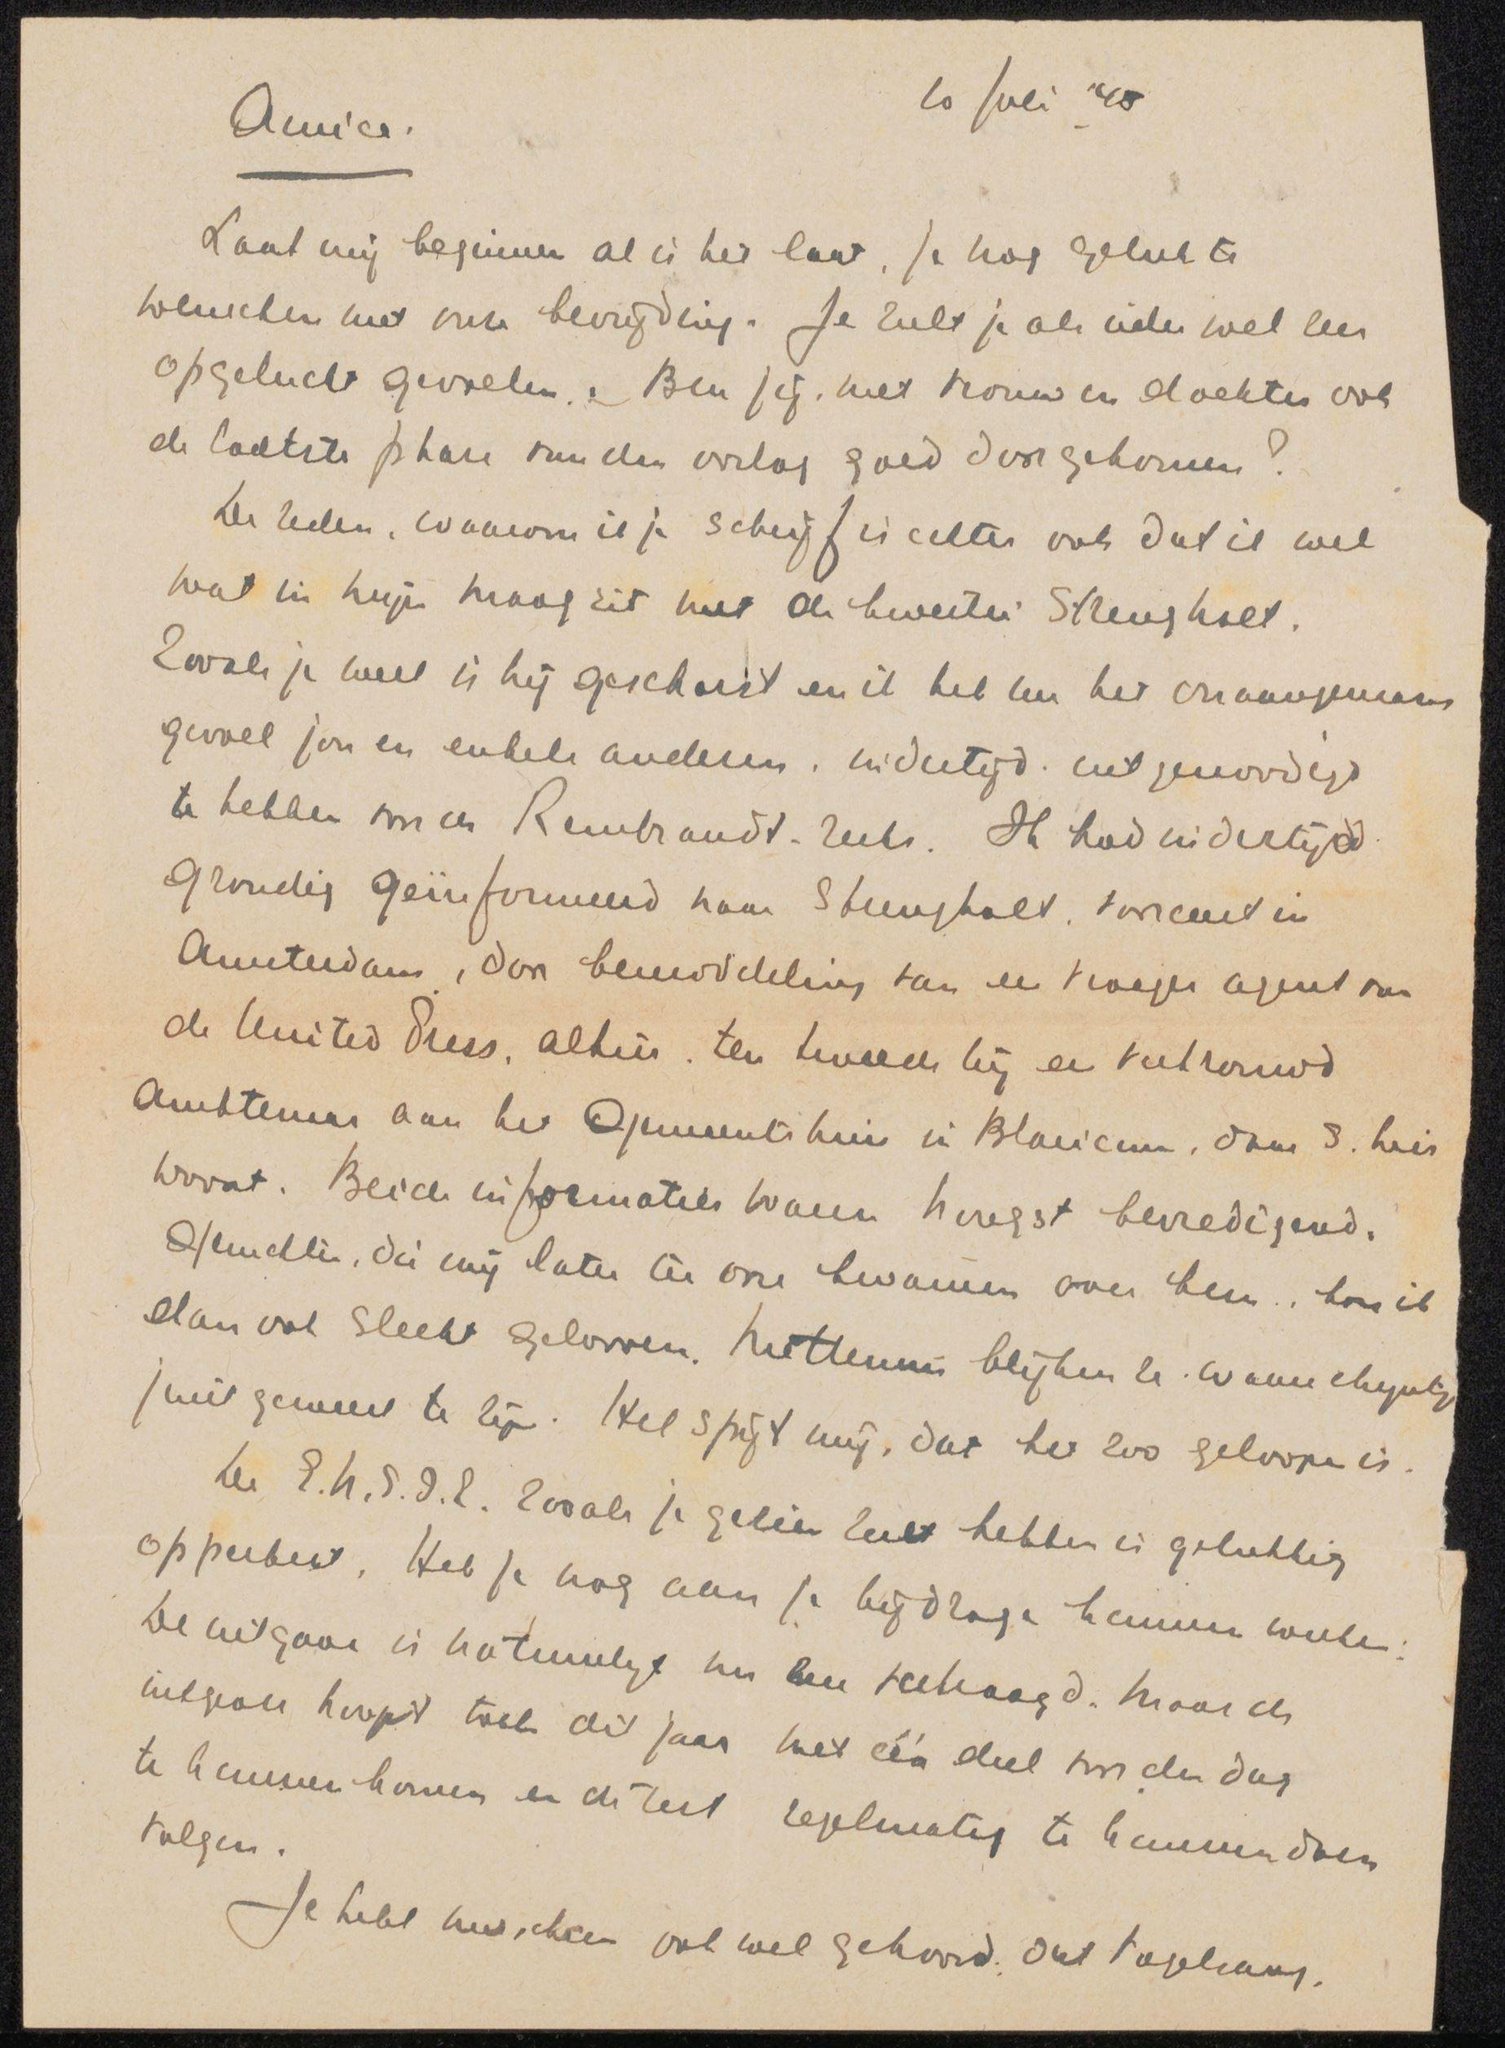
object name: letter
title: Brief aan A. van der Boom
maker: jacob samuel witsen elias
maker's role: schrijver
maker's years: 1898-1977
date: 1945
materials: ink, paper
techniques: pen, writing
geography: blaricum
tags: publisher, a. van der boom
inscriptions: collector's mark: Lugt L.2228a